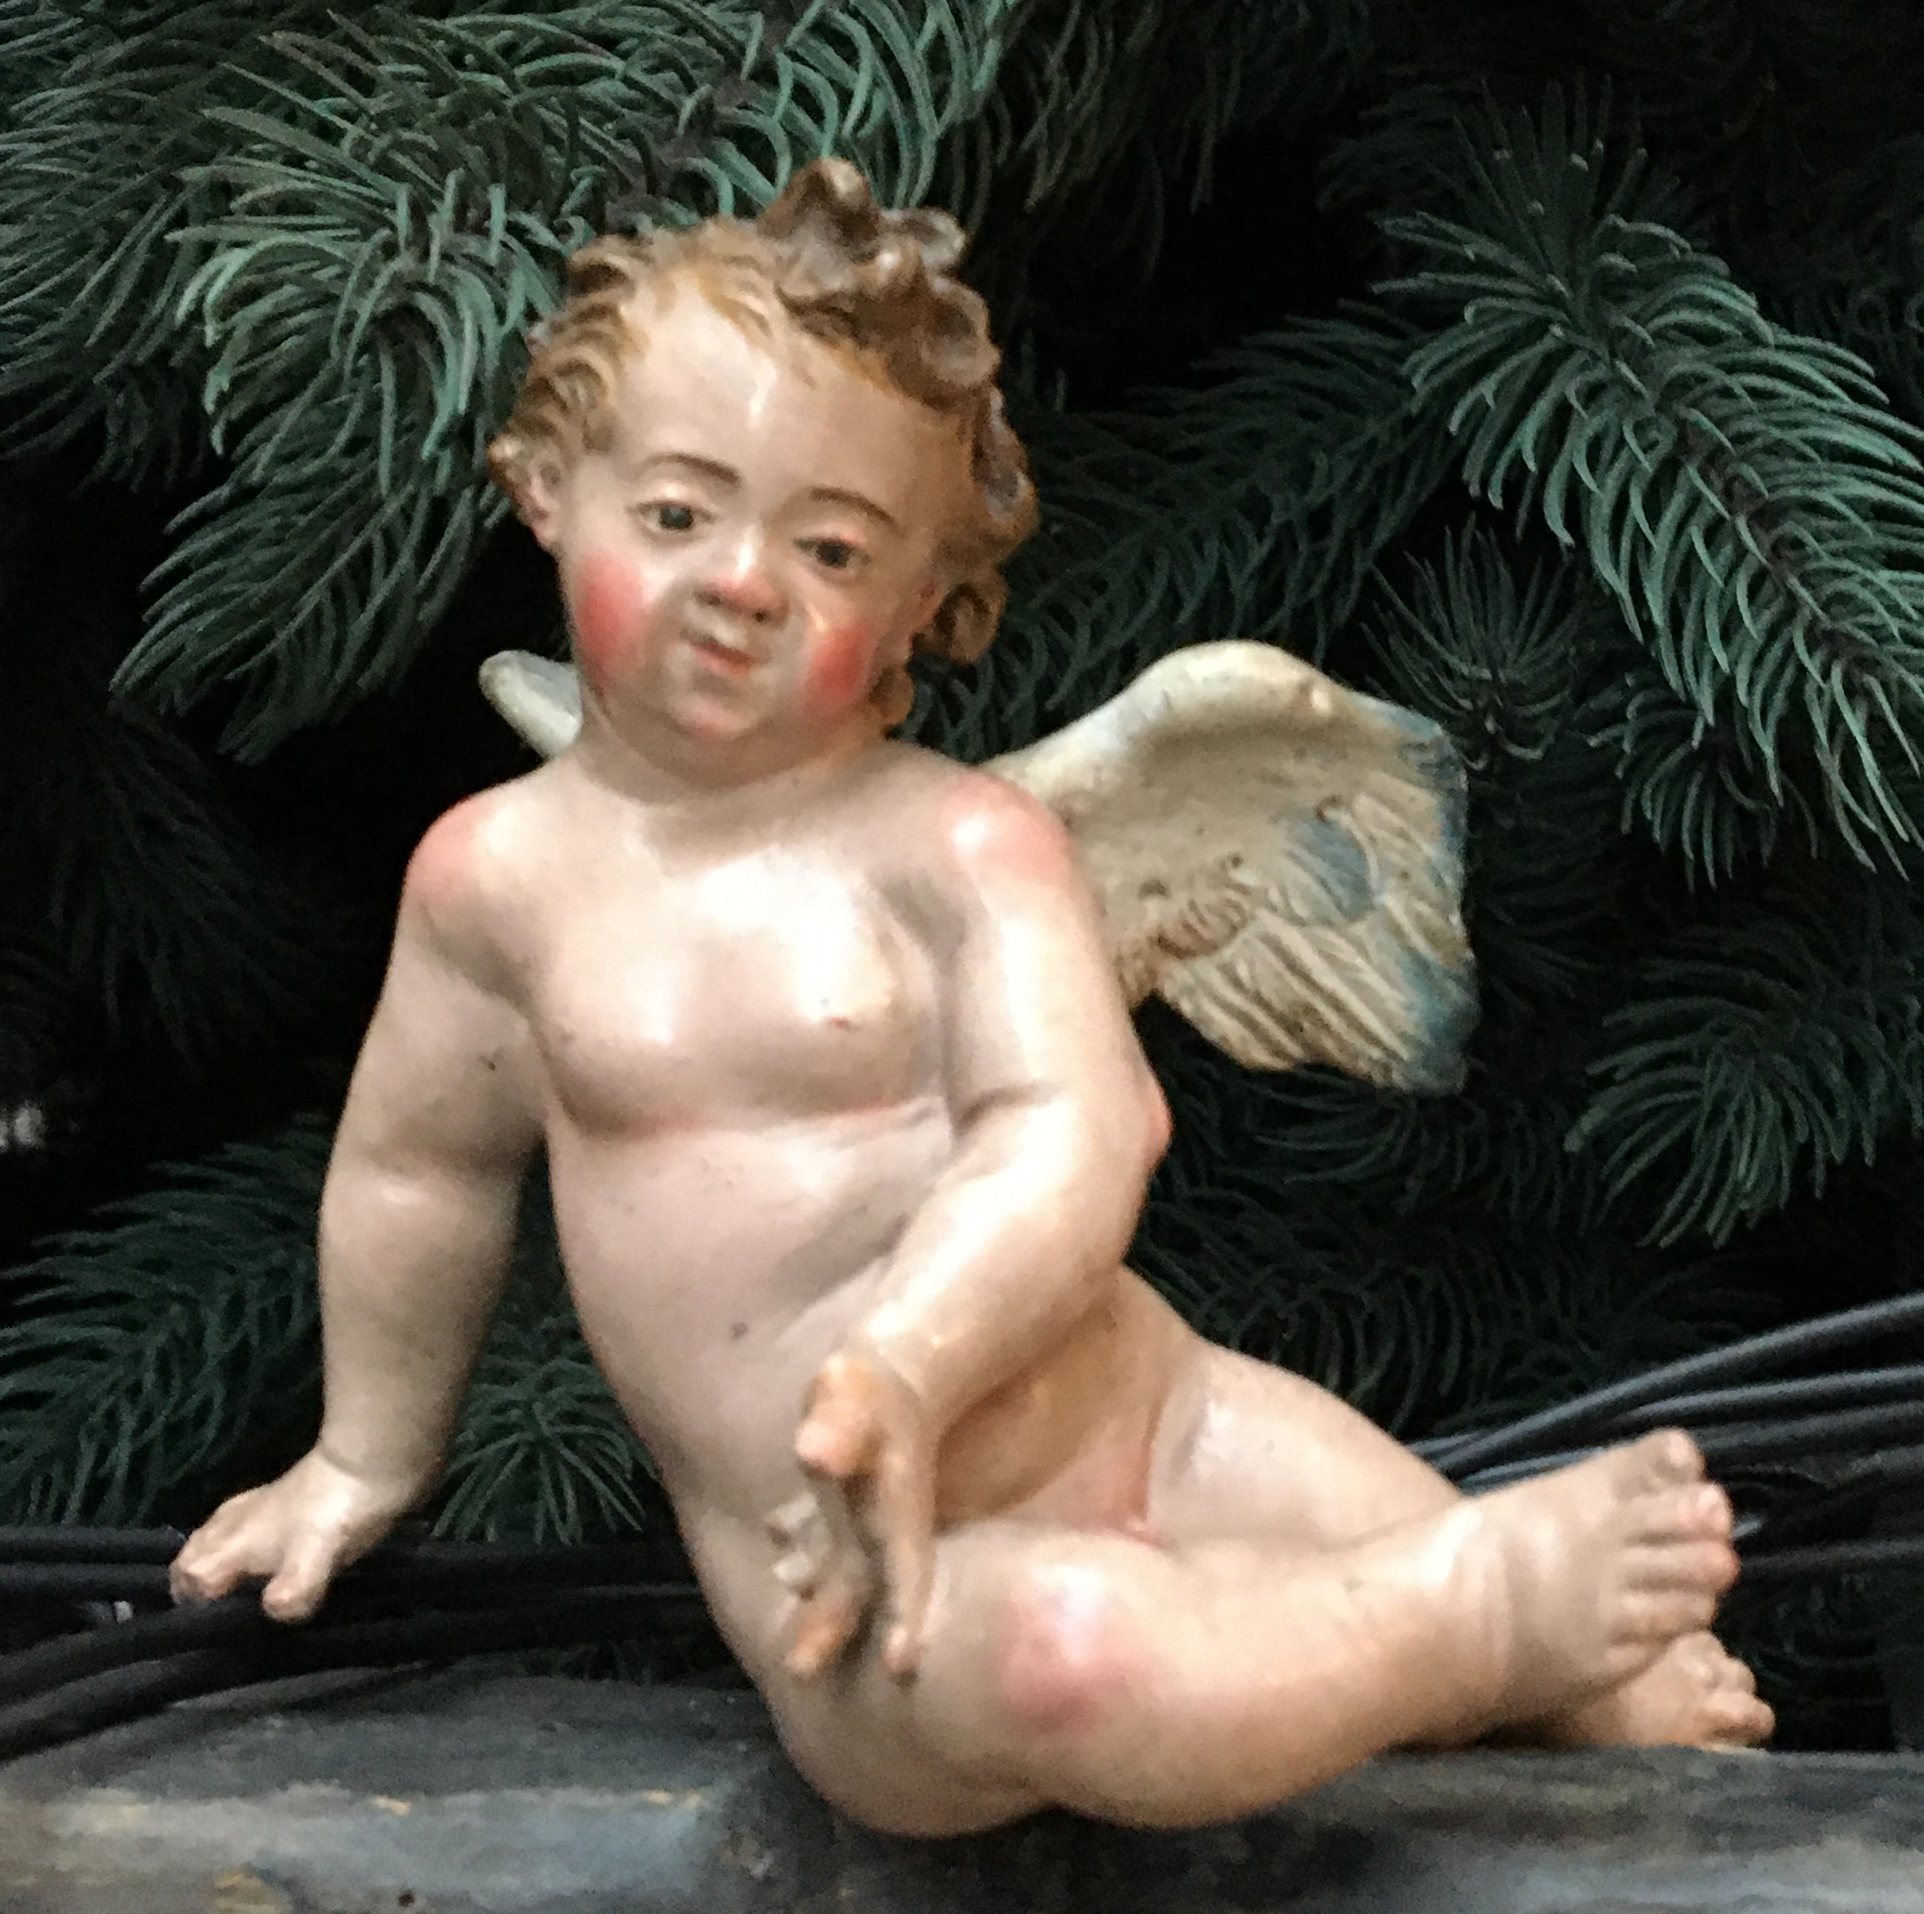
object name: crèche figure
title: Cherub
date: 1751-1800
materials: terracotta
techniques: polychrome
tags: angels